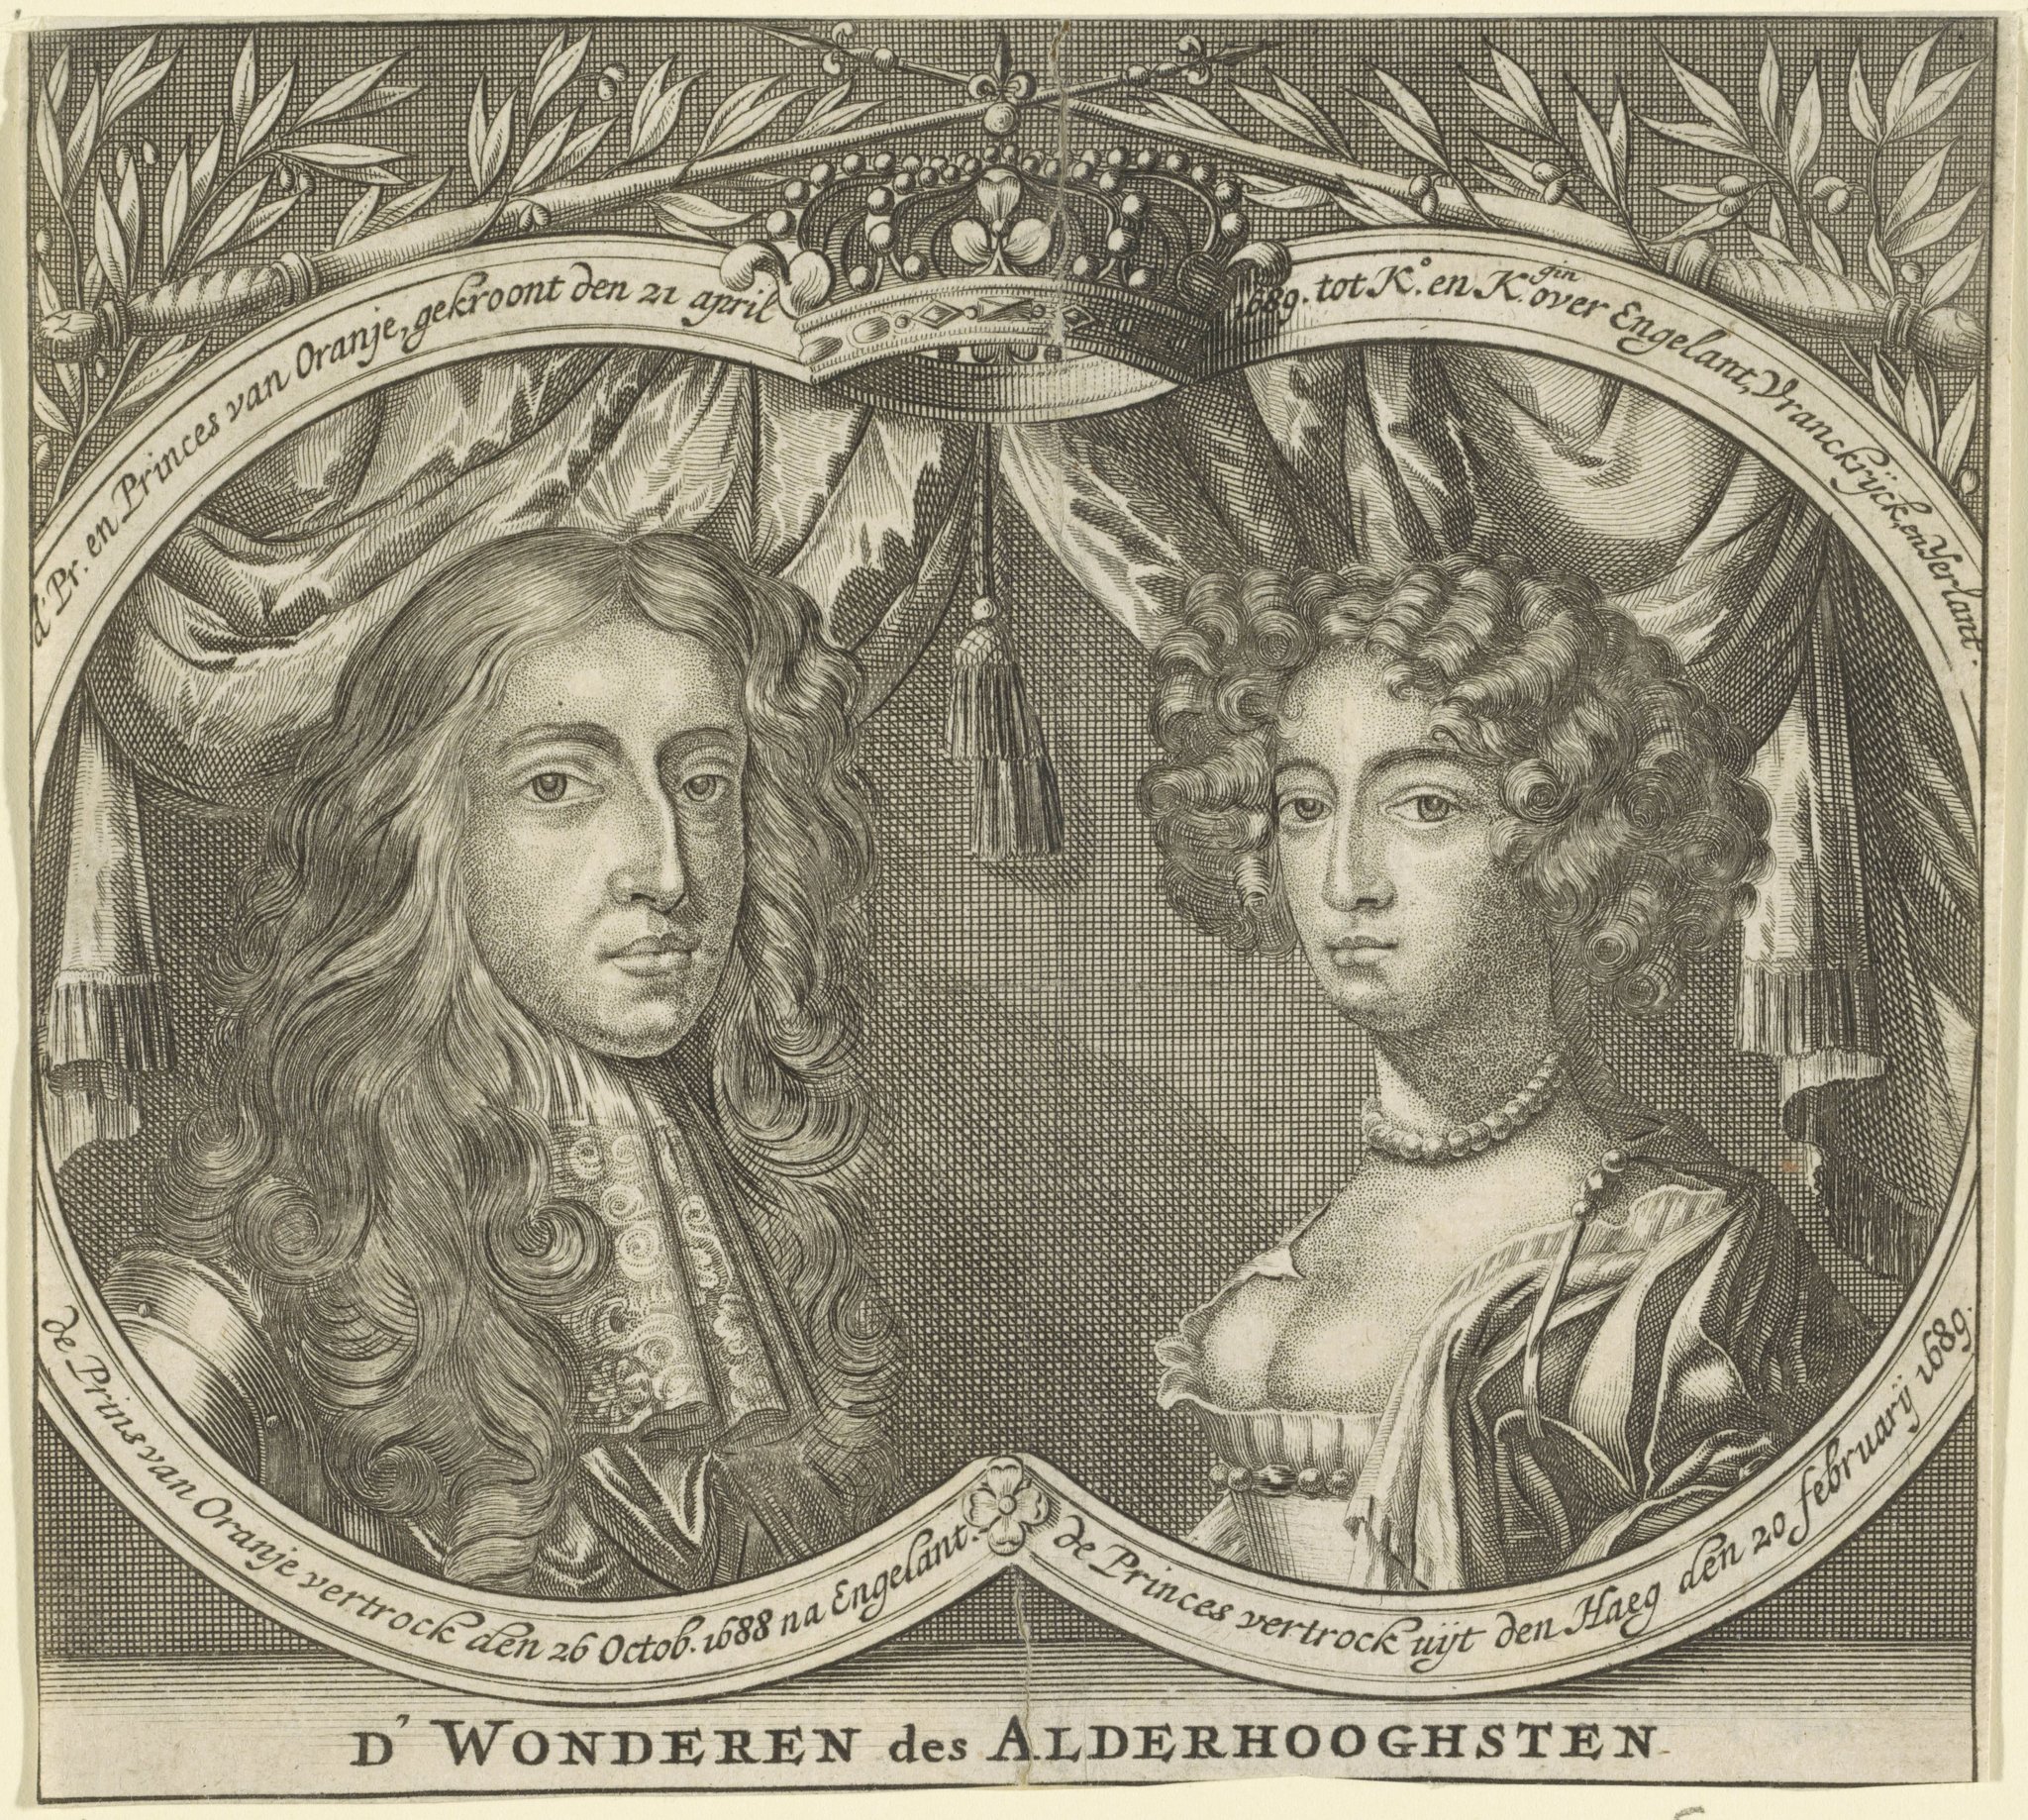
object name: print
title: Portret van Willem III, prins van Oranje, en Maria II Stuart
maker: Anonymous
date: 1688-1749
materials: paper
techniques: engraving, etching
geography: low countries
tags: the hague, william iii (prince of orange and king of england, scotland, and ireland), london, maria ii stuart (koningin van engeland, schotland en ierland)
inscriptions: collector's mark: Lugt 963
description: Portret van Willem III en Maria II in een dubbele ovaal met randschrift. Midden boven een kroon. In de ondermarge een regel Nederlandse tekst.